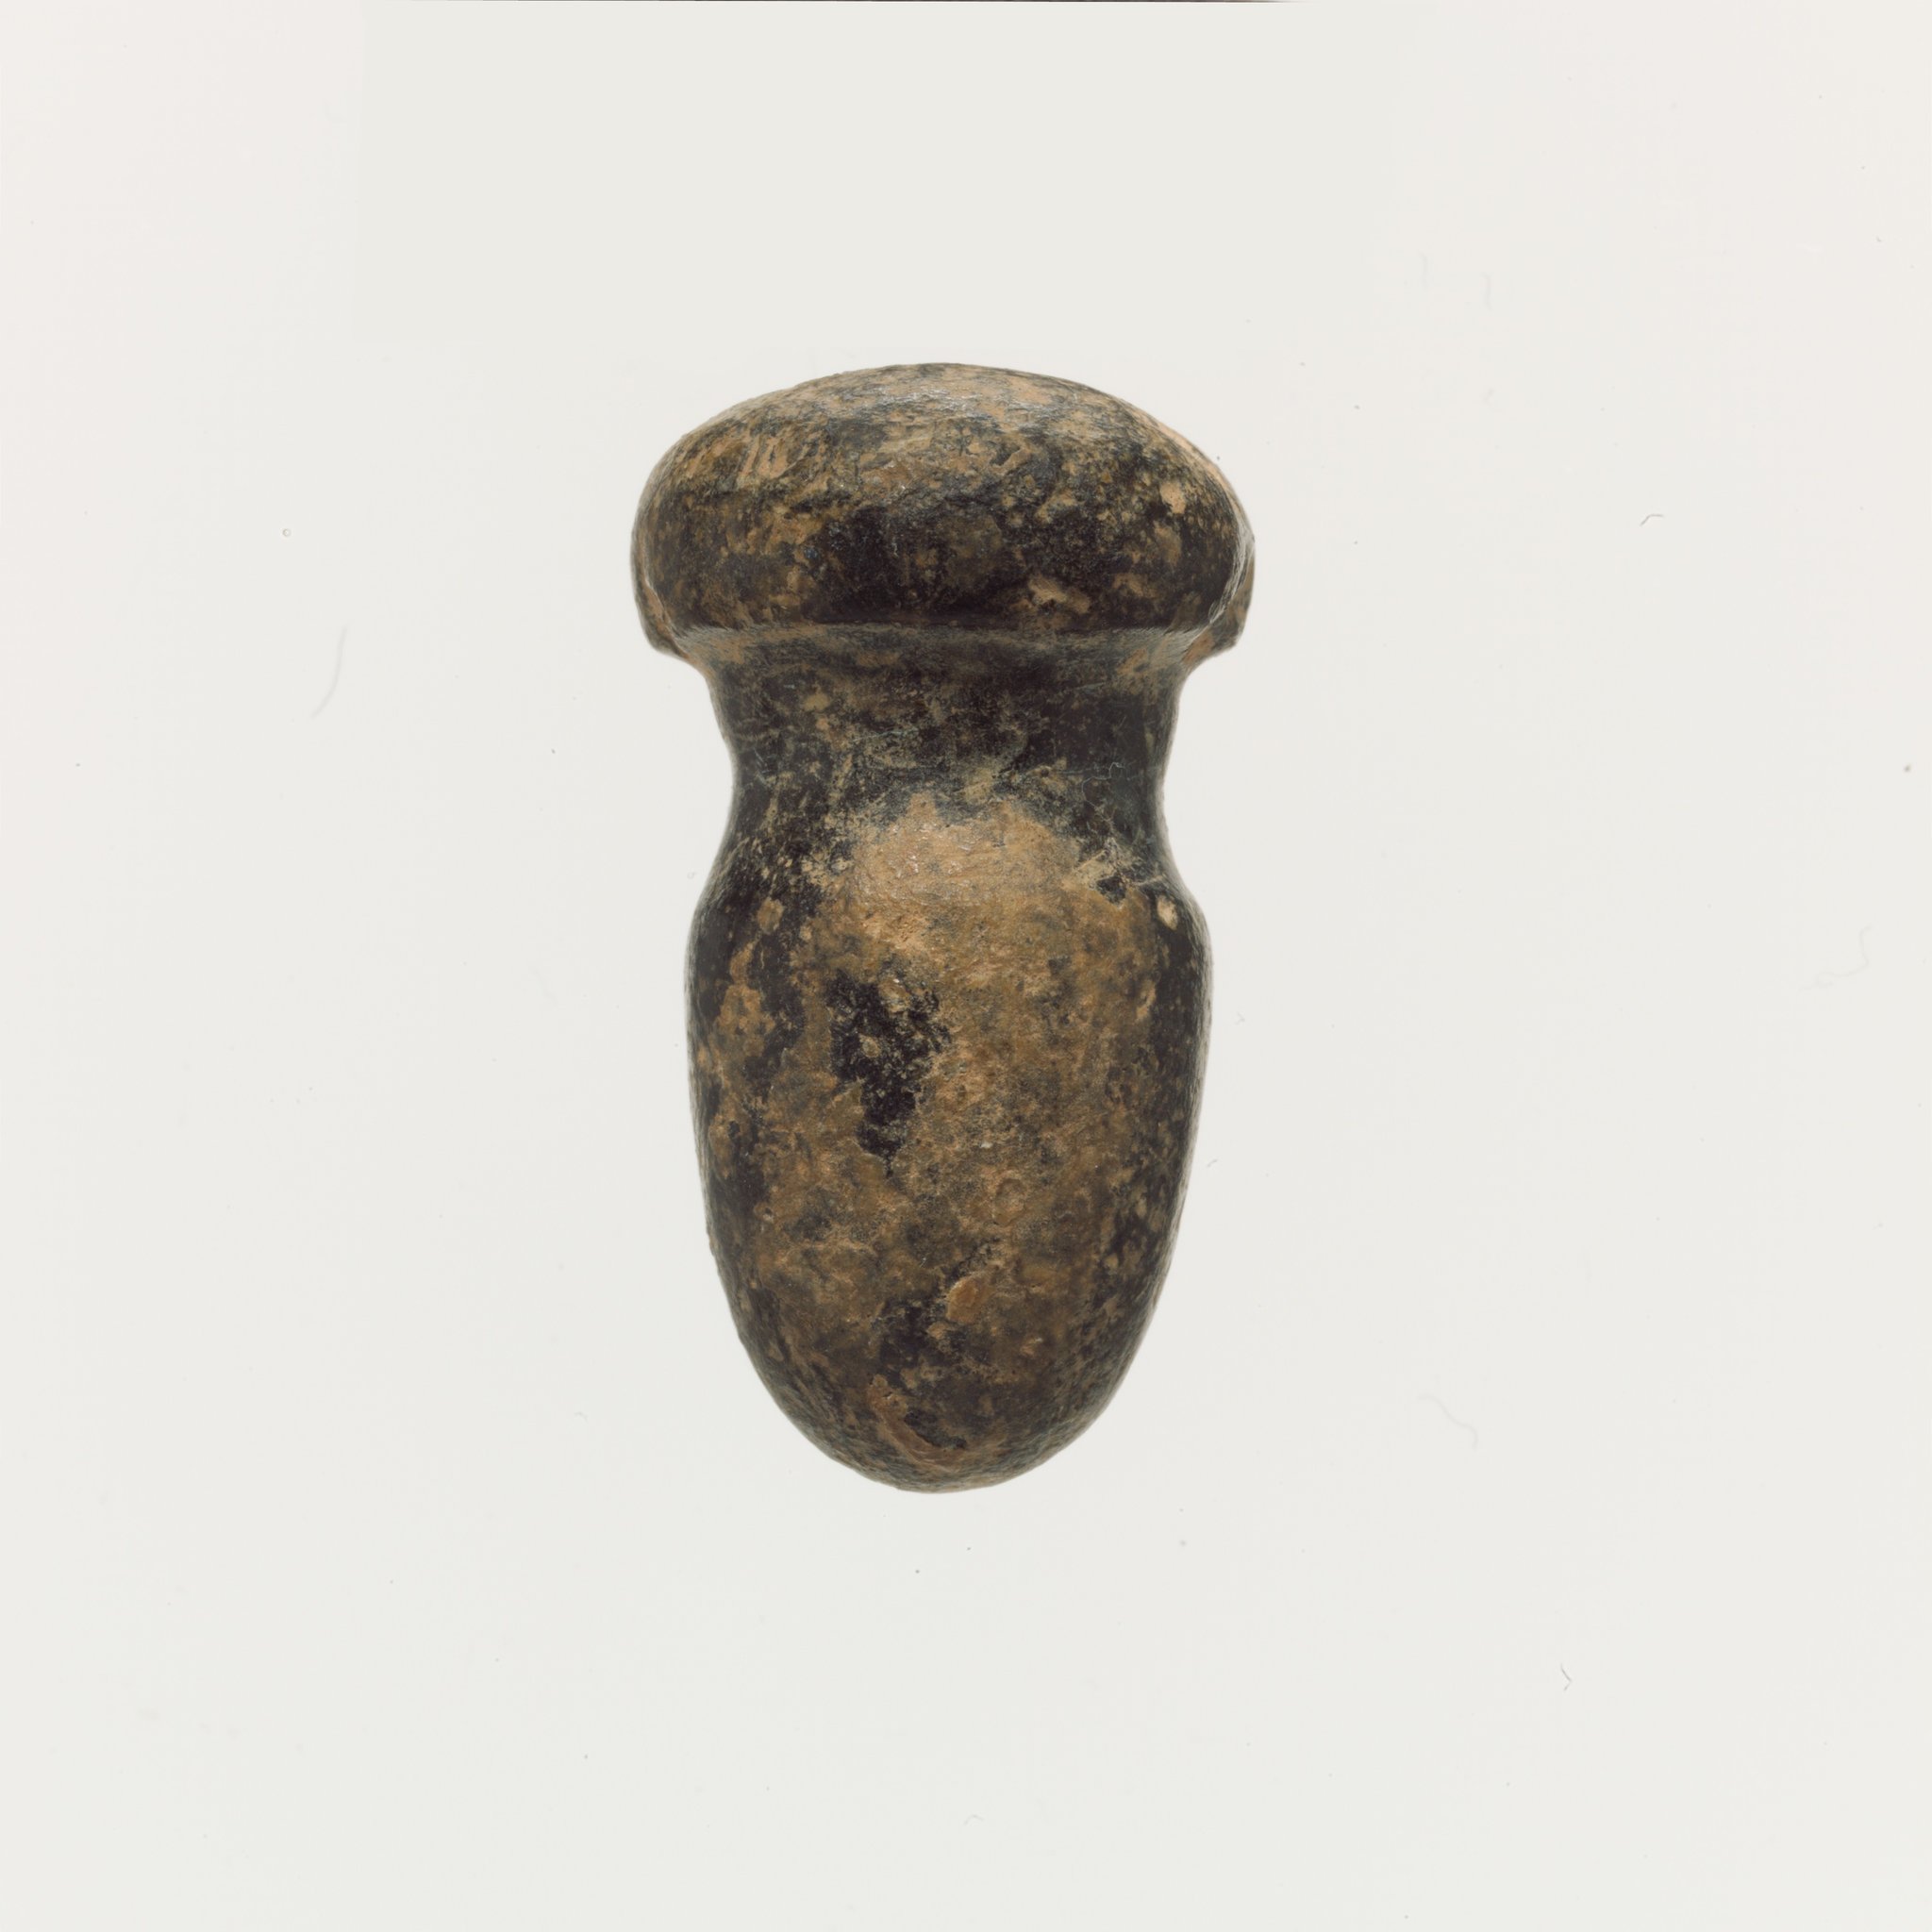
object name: pendant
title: Steatite pendant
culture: minoan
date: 2900-1900 BCE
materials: stone